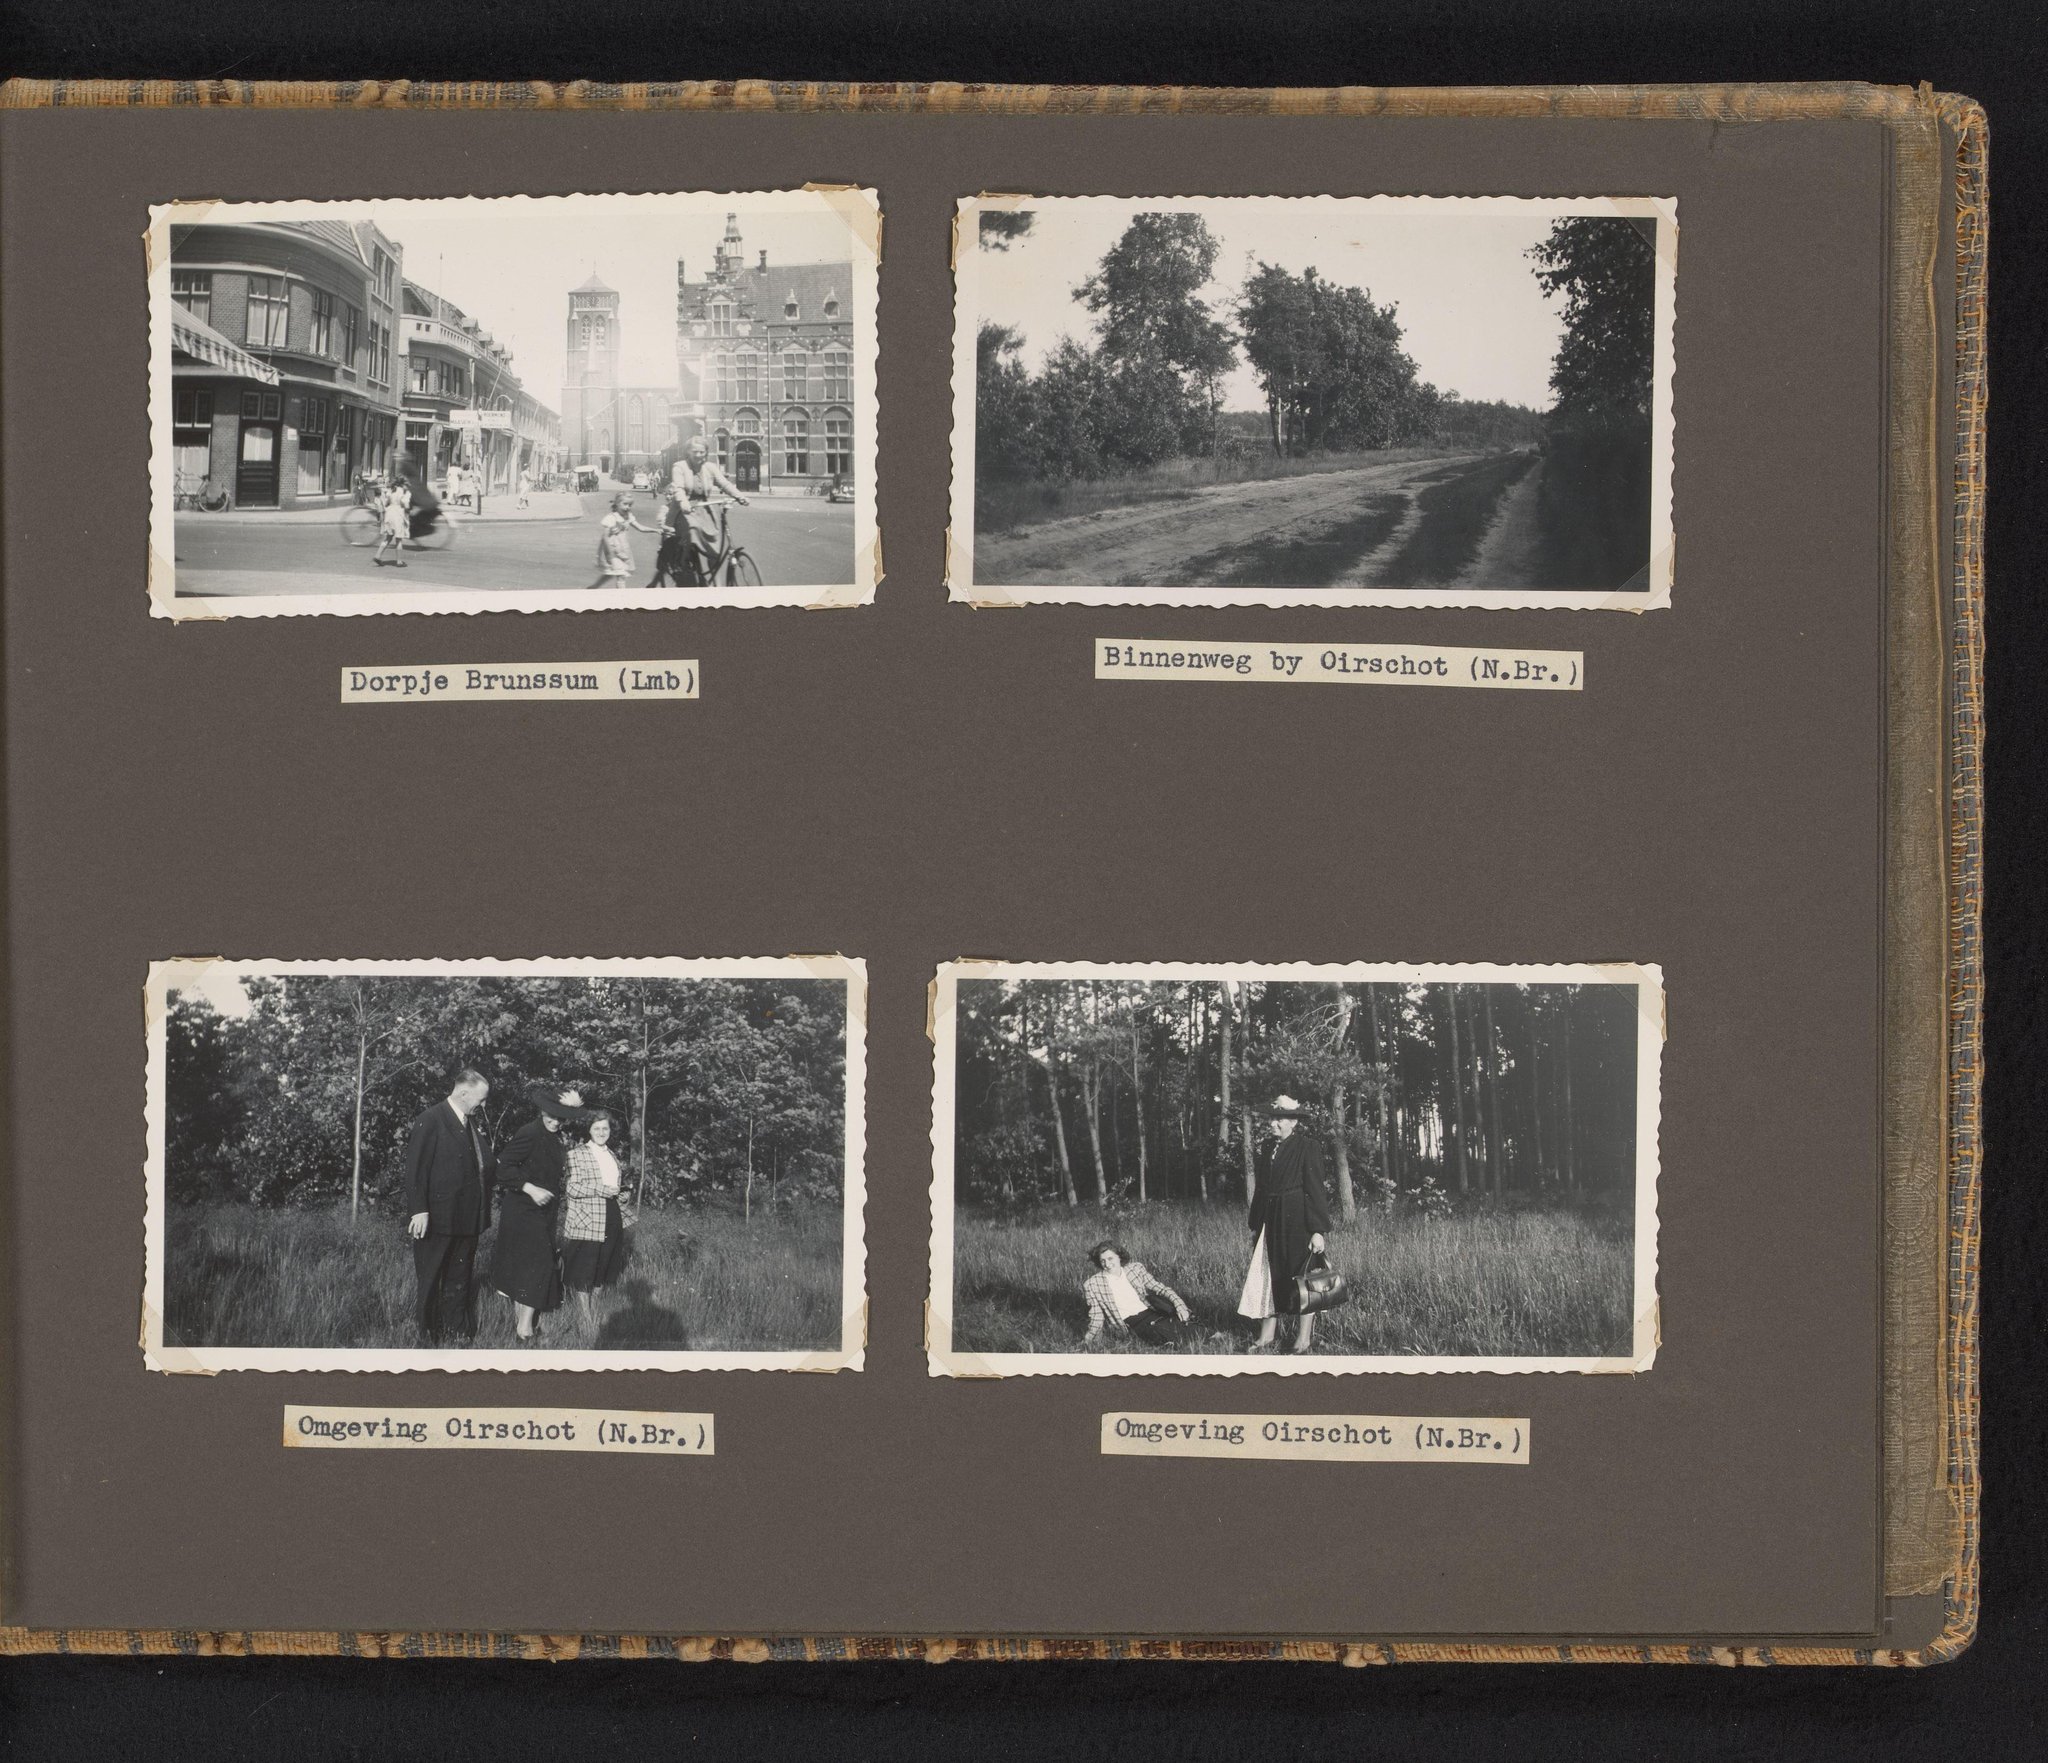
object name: photograph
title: Oirschot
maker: Anonymous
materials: paper, photographic support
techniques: gelatin silver print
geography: netherlands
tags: the family travelling, on holiday, outing, pleasure trip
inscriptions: inscription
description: Albumblad met vier foto's bij Oirschot en Brunssum. Onder de foto's uitgeknipte papiertjes met getypte opschriften. Onderdeel van het eerste fotoalbum met foto's van de twee fietstochten van vader en zoon door Nederland in september 1939 en juli 1940 en een autotrip met het gezin door Nederland, België en Luxemburg in juni 1949.